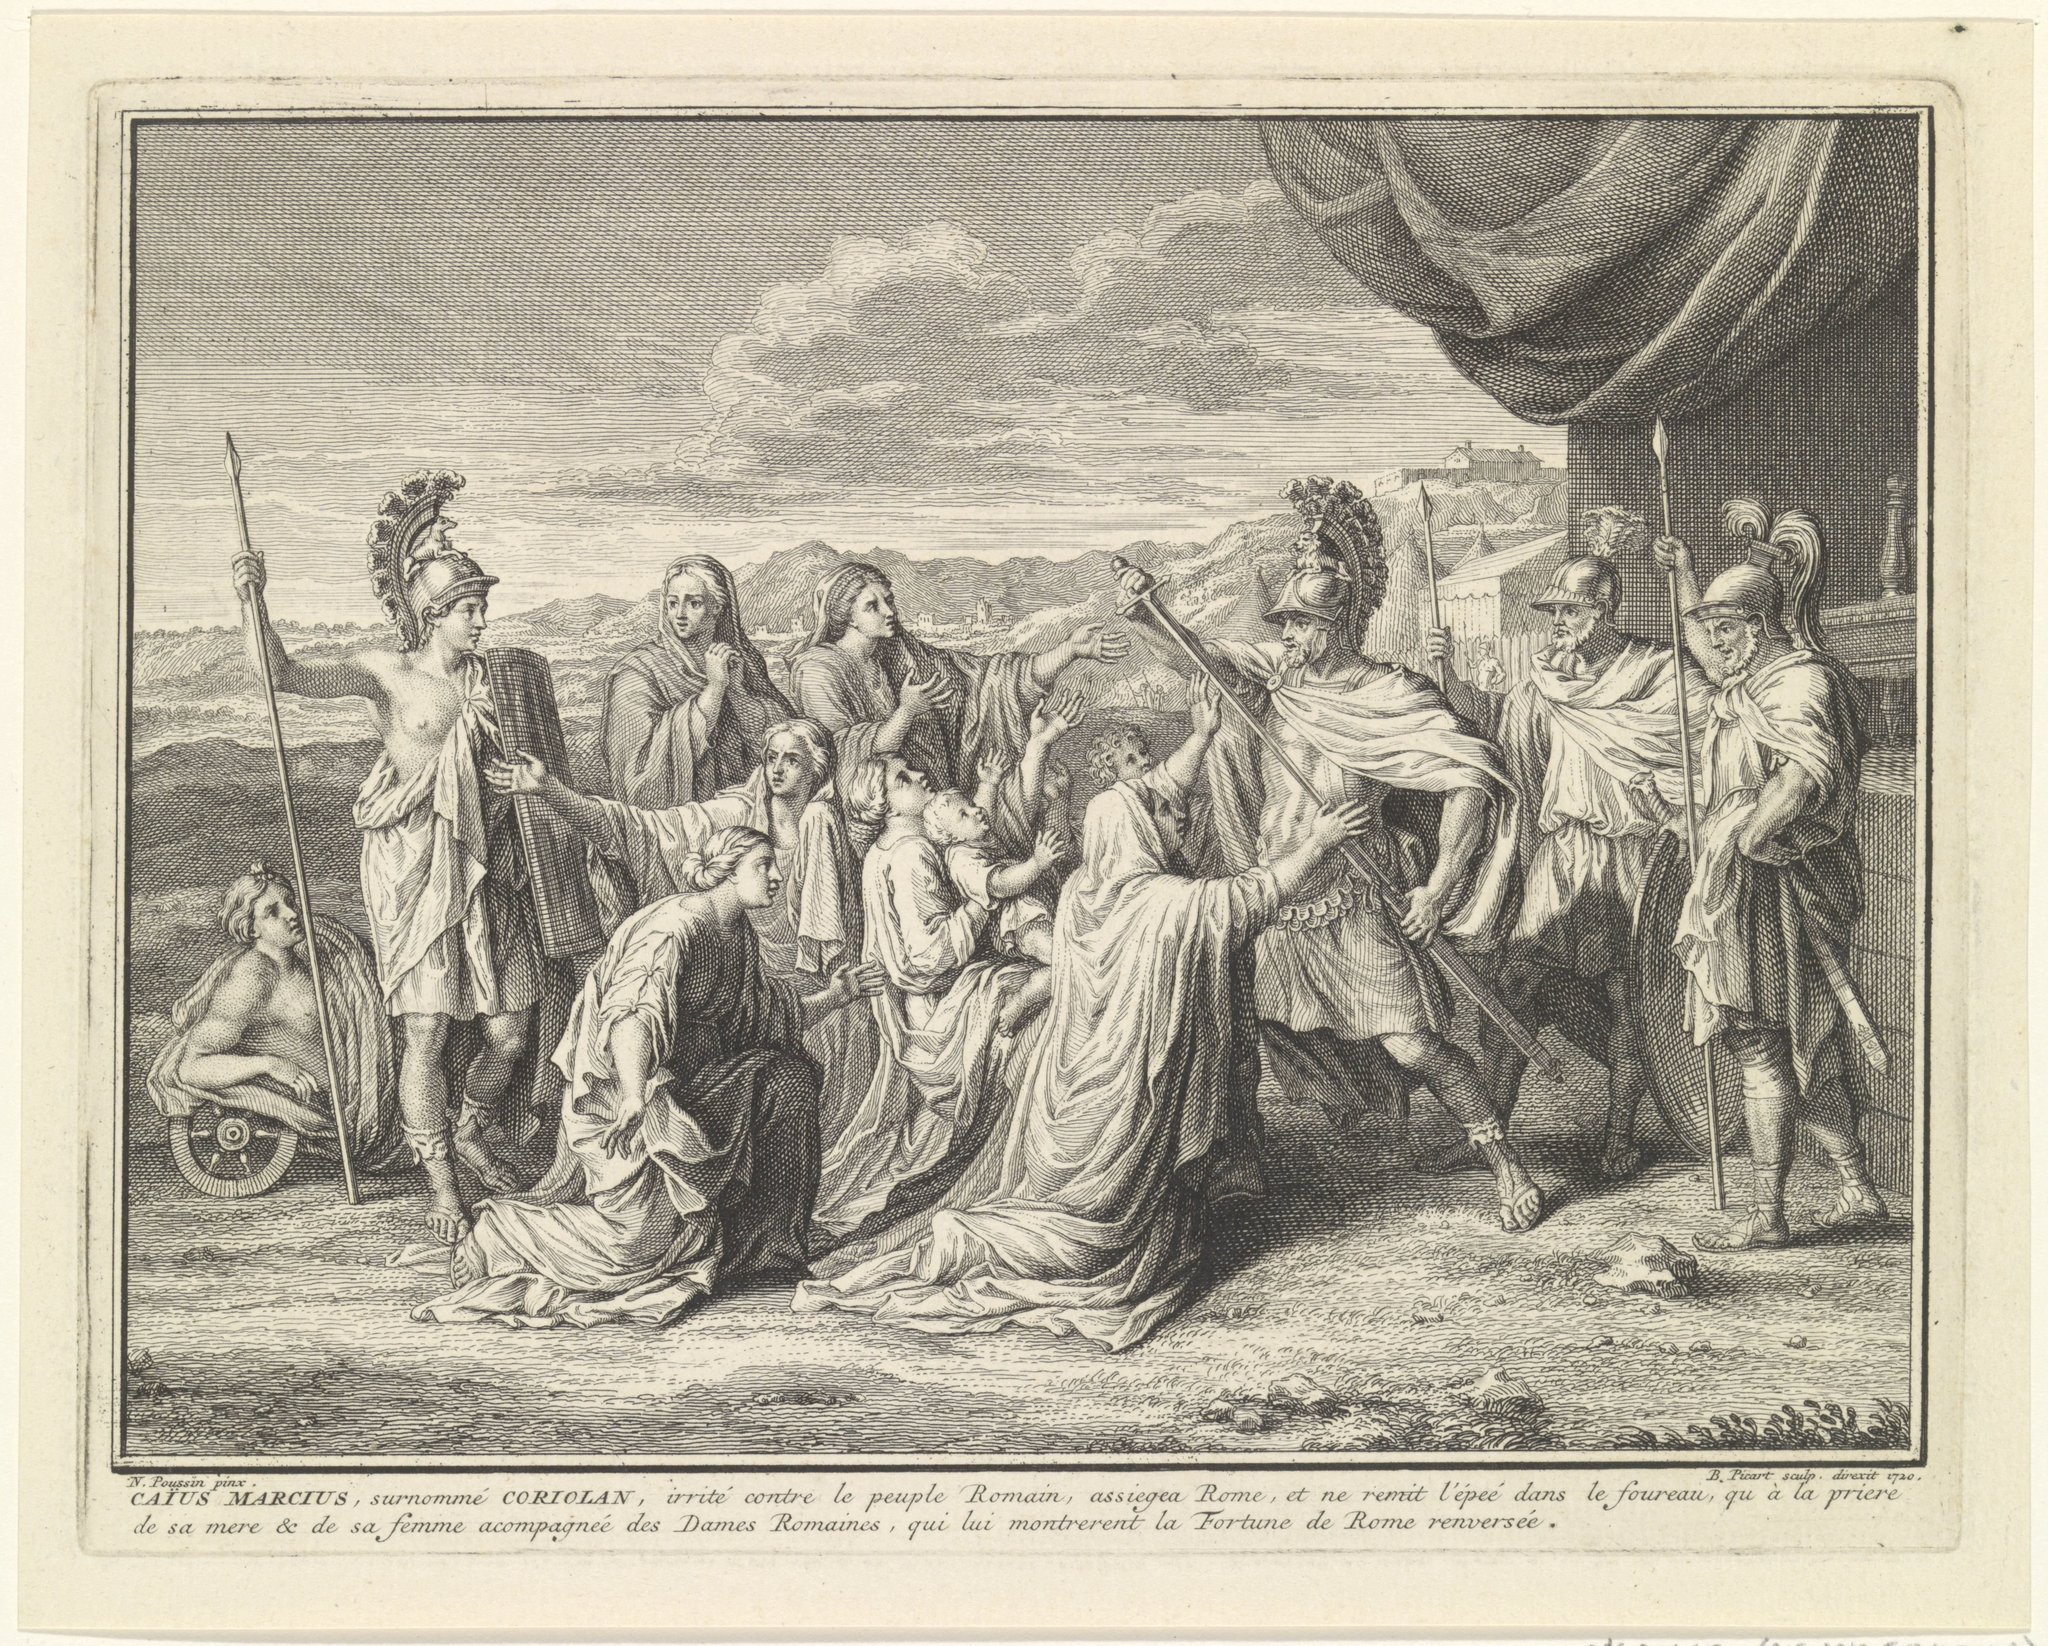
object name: print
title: Coriolanus omringd door smekende vrouwen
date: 1720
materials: paper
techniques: engraving, etching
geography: amsterdam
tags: coriolanus (c. or cn. marcius) is met by his wife volumnia (alternatively called vergilia) with their two small sons, and his mother veturia (alternatively called volumnia); they entreat him not to fight any more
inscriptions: date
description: Coriolanus trekt zijn zwaard en wordt omringd door zijn geknielde moeder, echtgenote en andere vrouwen die hem smeken Rome niet aan te vallen. In de marge een tweeregelig onderschrift in het Frans.